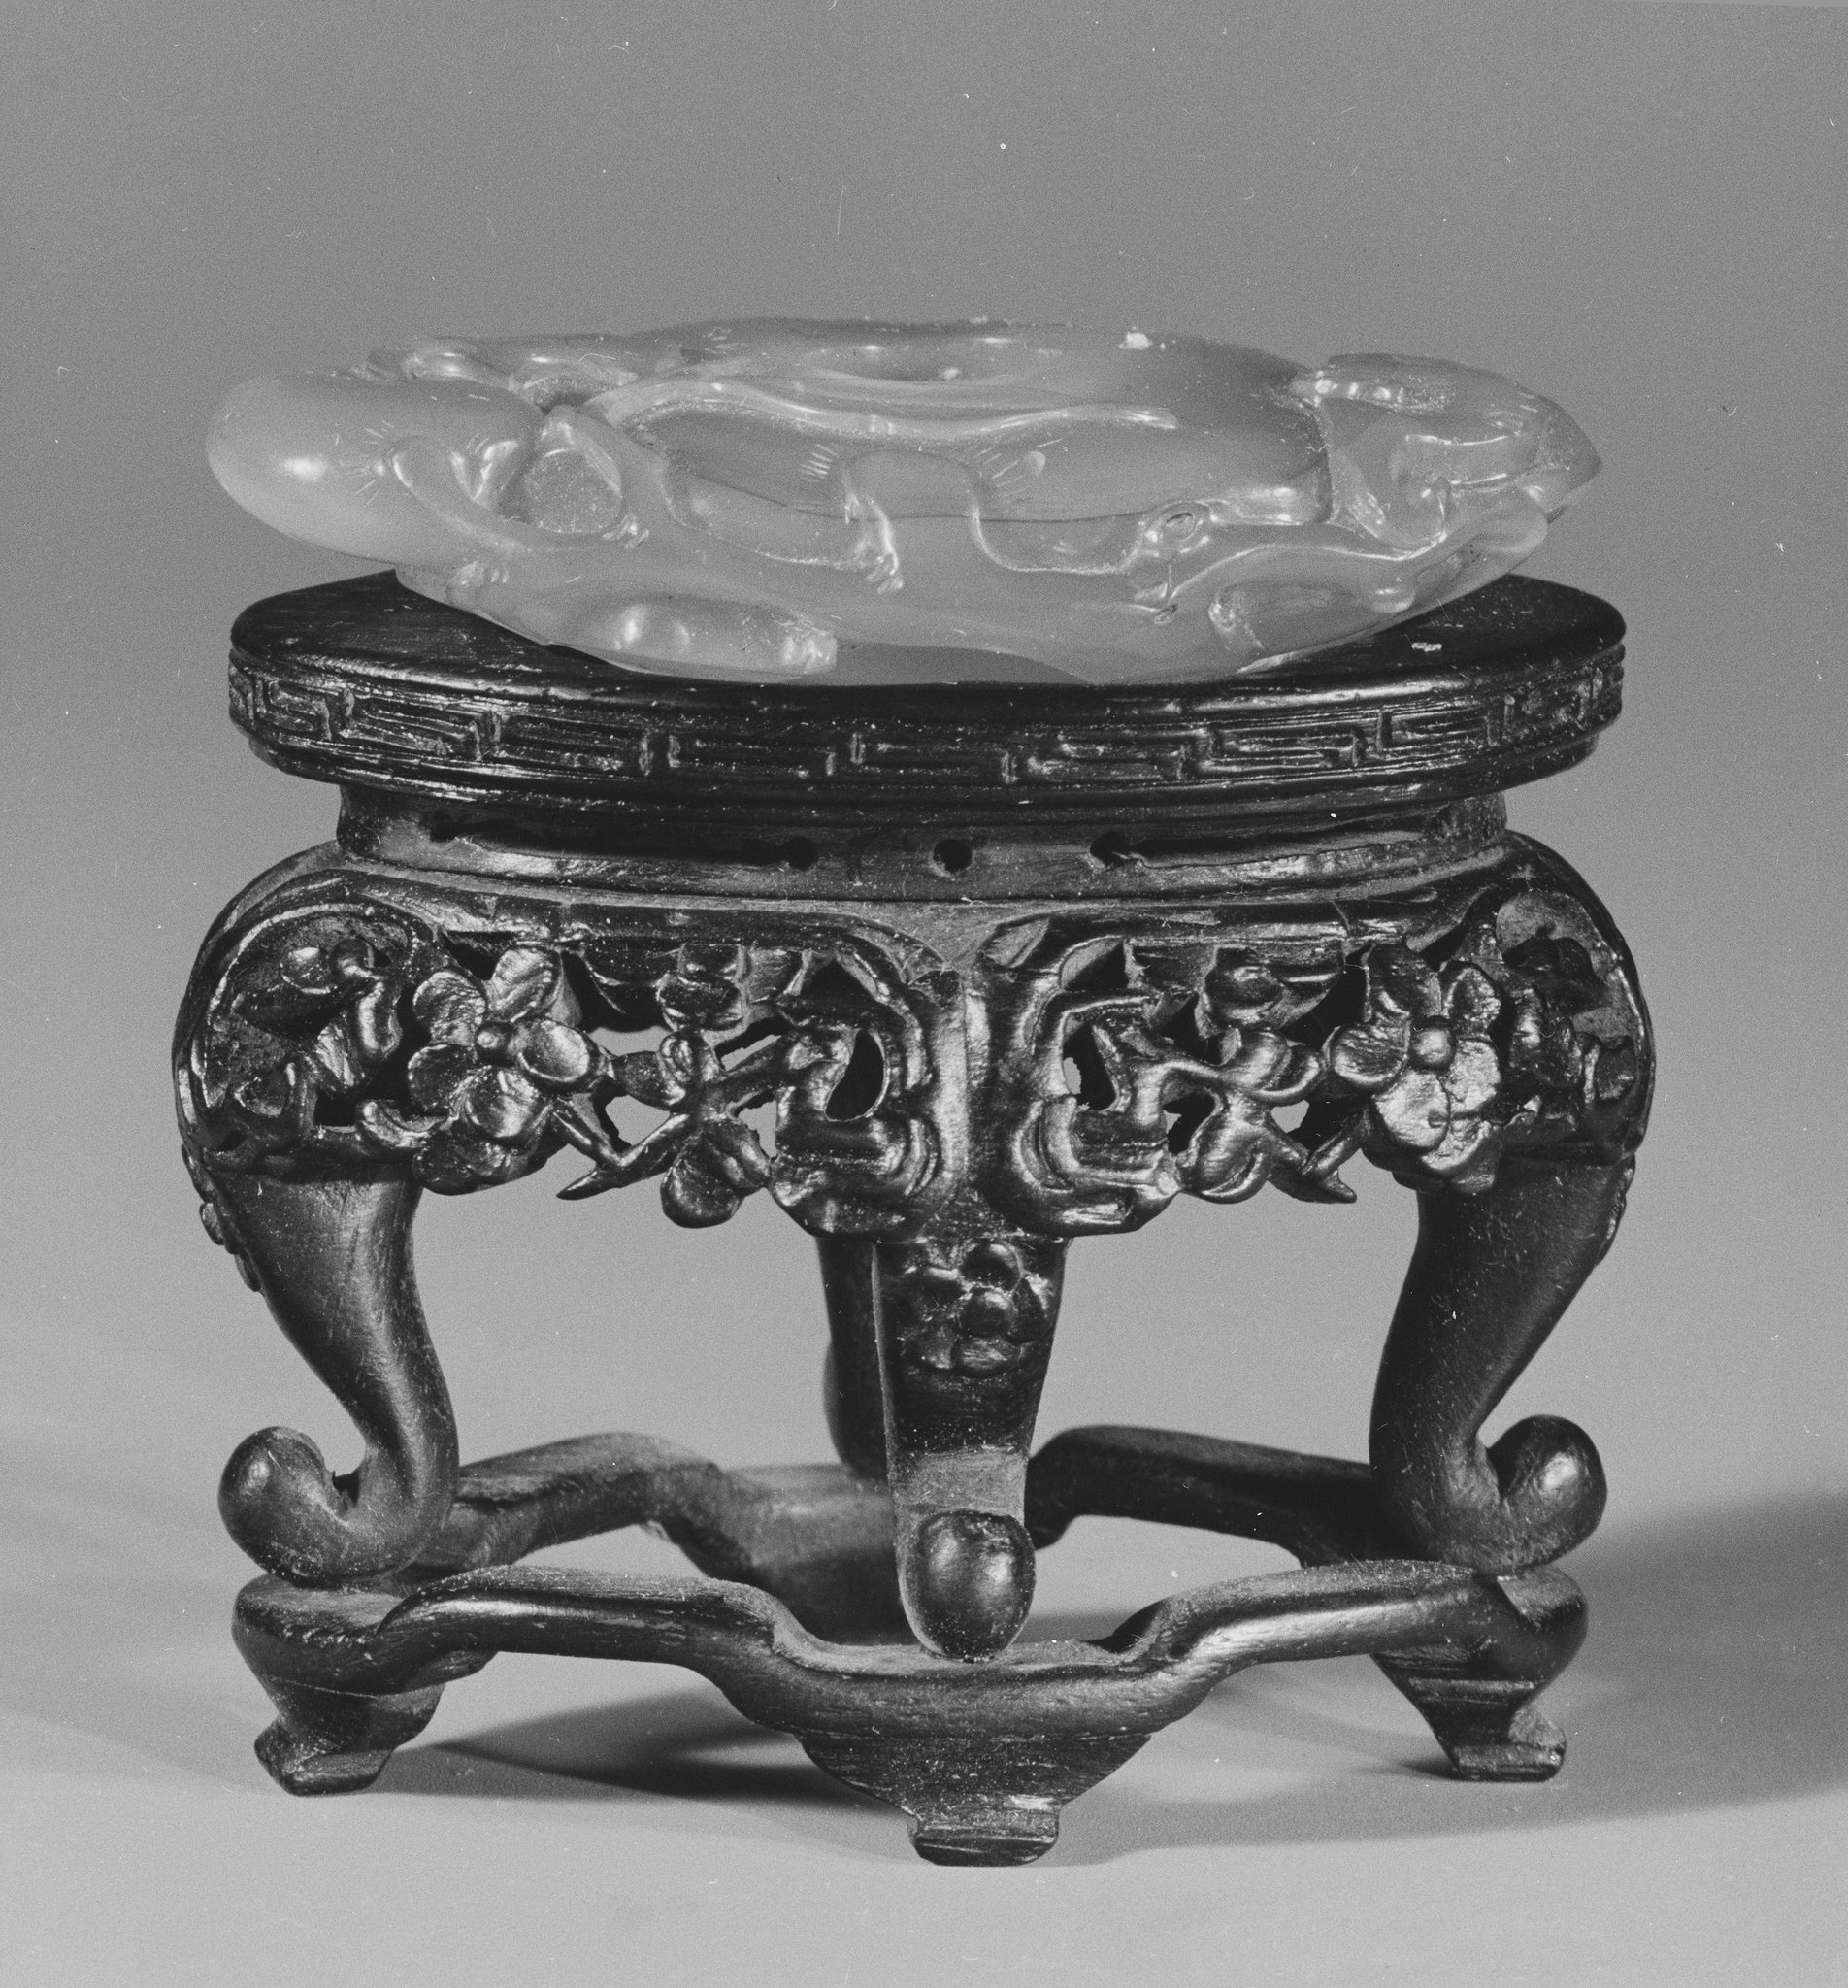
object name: water jar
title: Water jar in the shape of a flower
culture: chinese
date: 1801-1900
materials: gemstone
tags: flowers